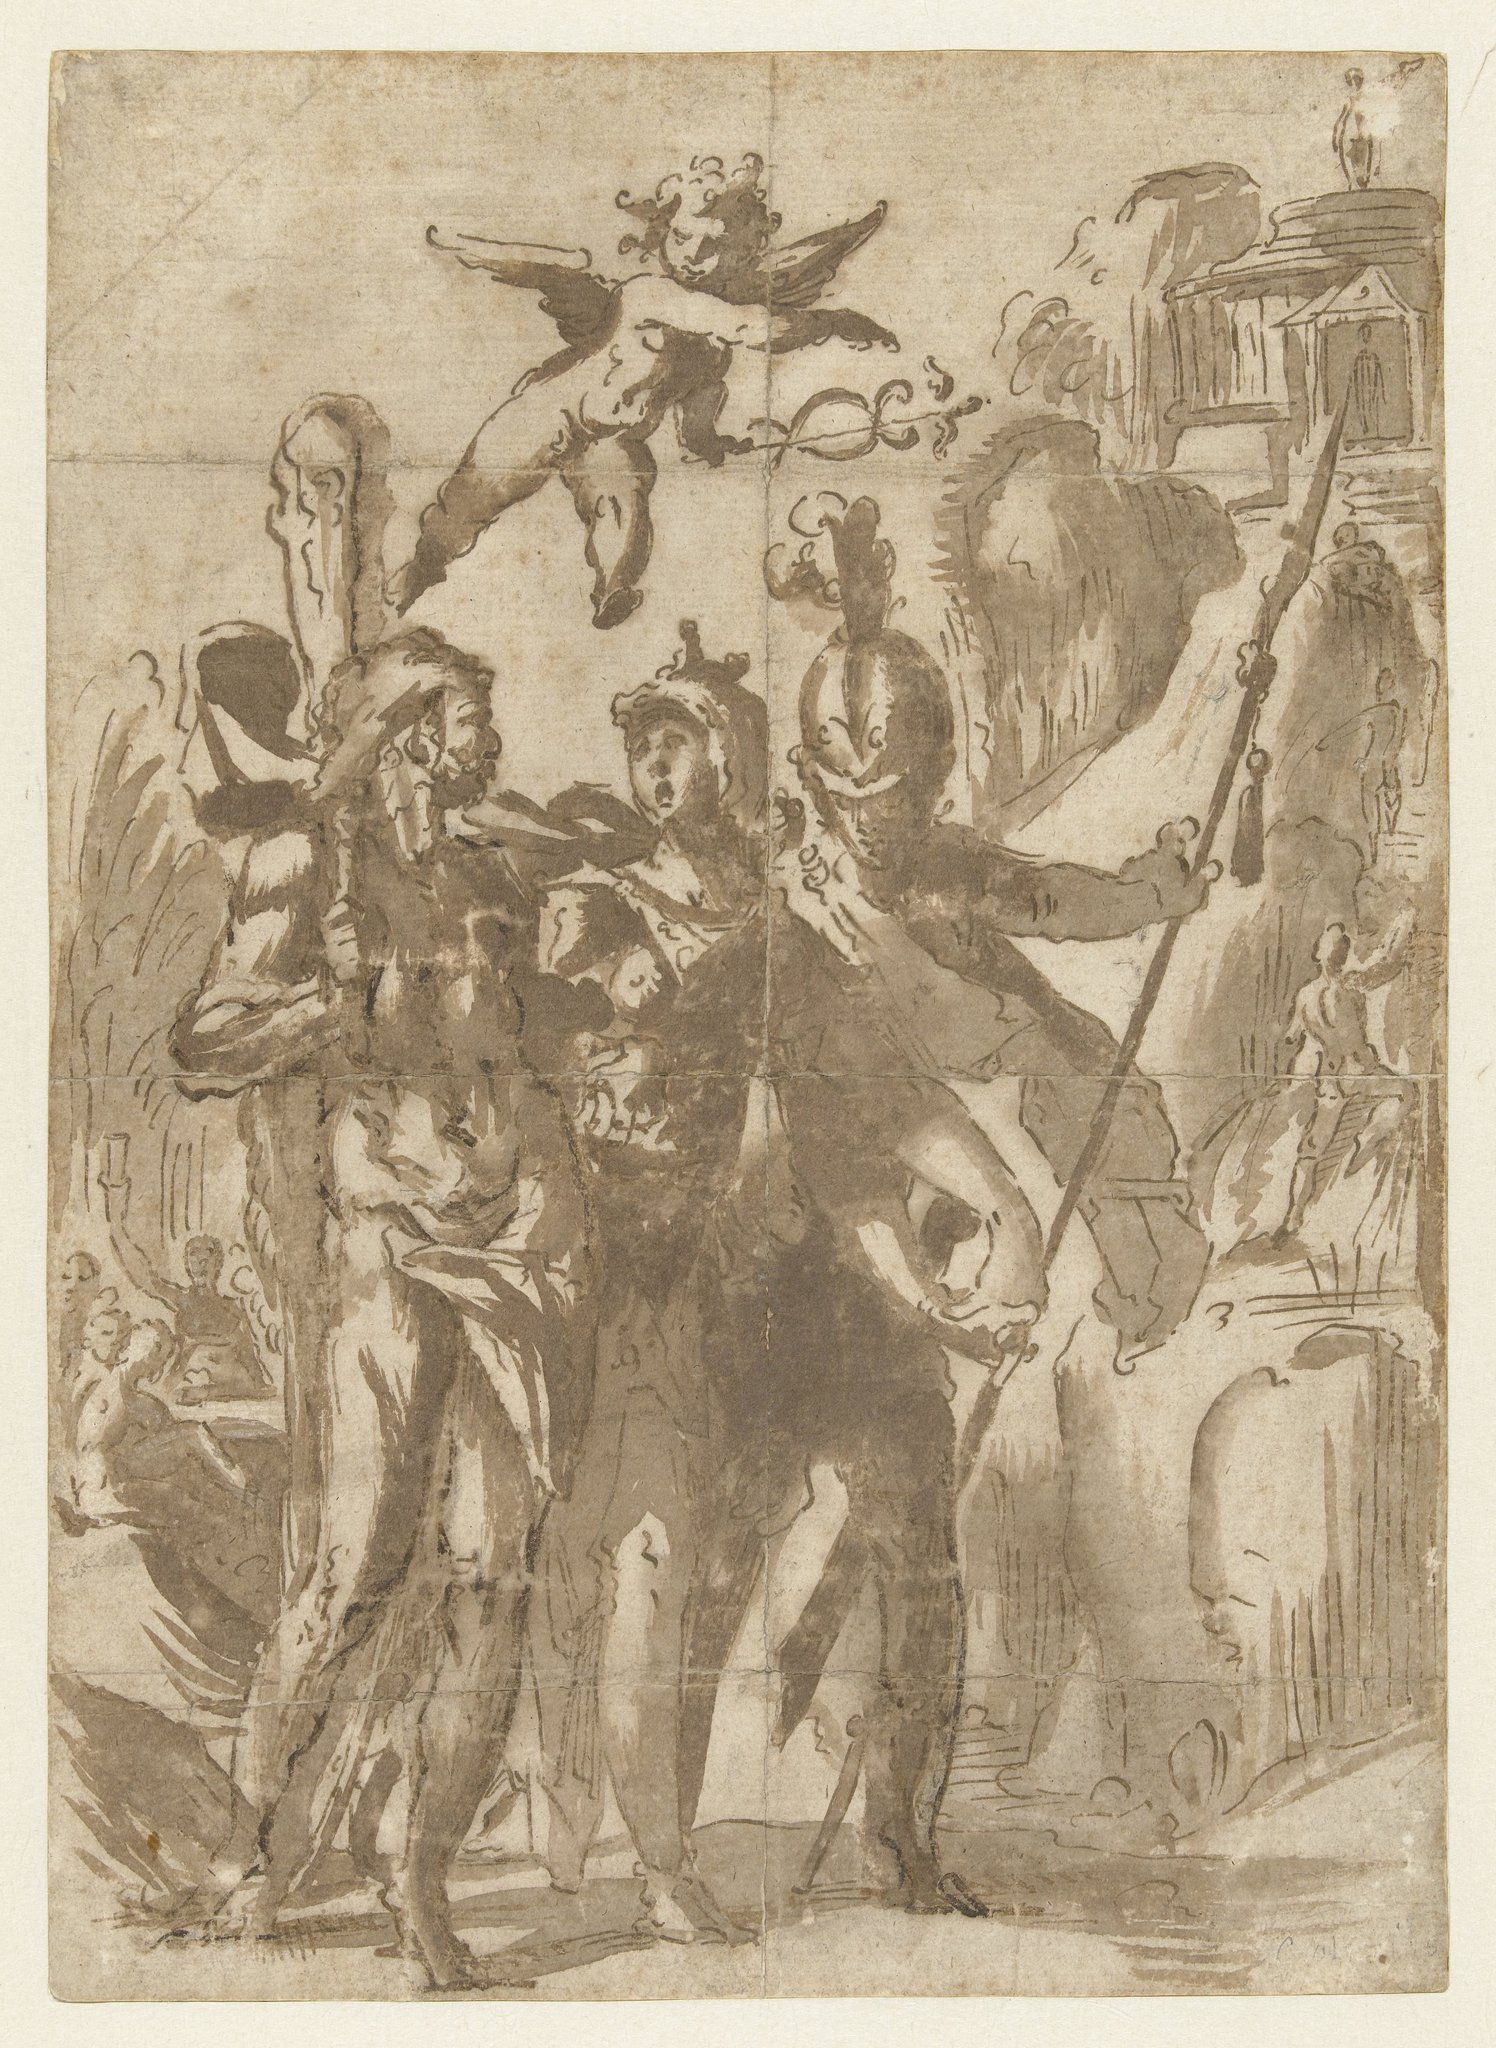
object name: drawing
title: Hercules en Scipio geleid door Minerva op het pad der deugd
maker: bartholomeus spranger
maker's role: draughtsman, painter, print maker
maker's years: 1546-1611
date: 1591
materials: chalk, ink, paper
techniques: brush, pen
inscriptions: collector's mark: ‘H. Hamal (L 1231)’